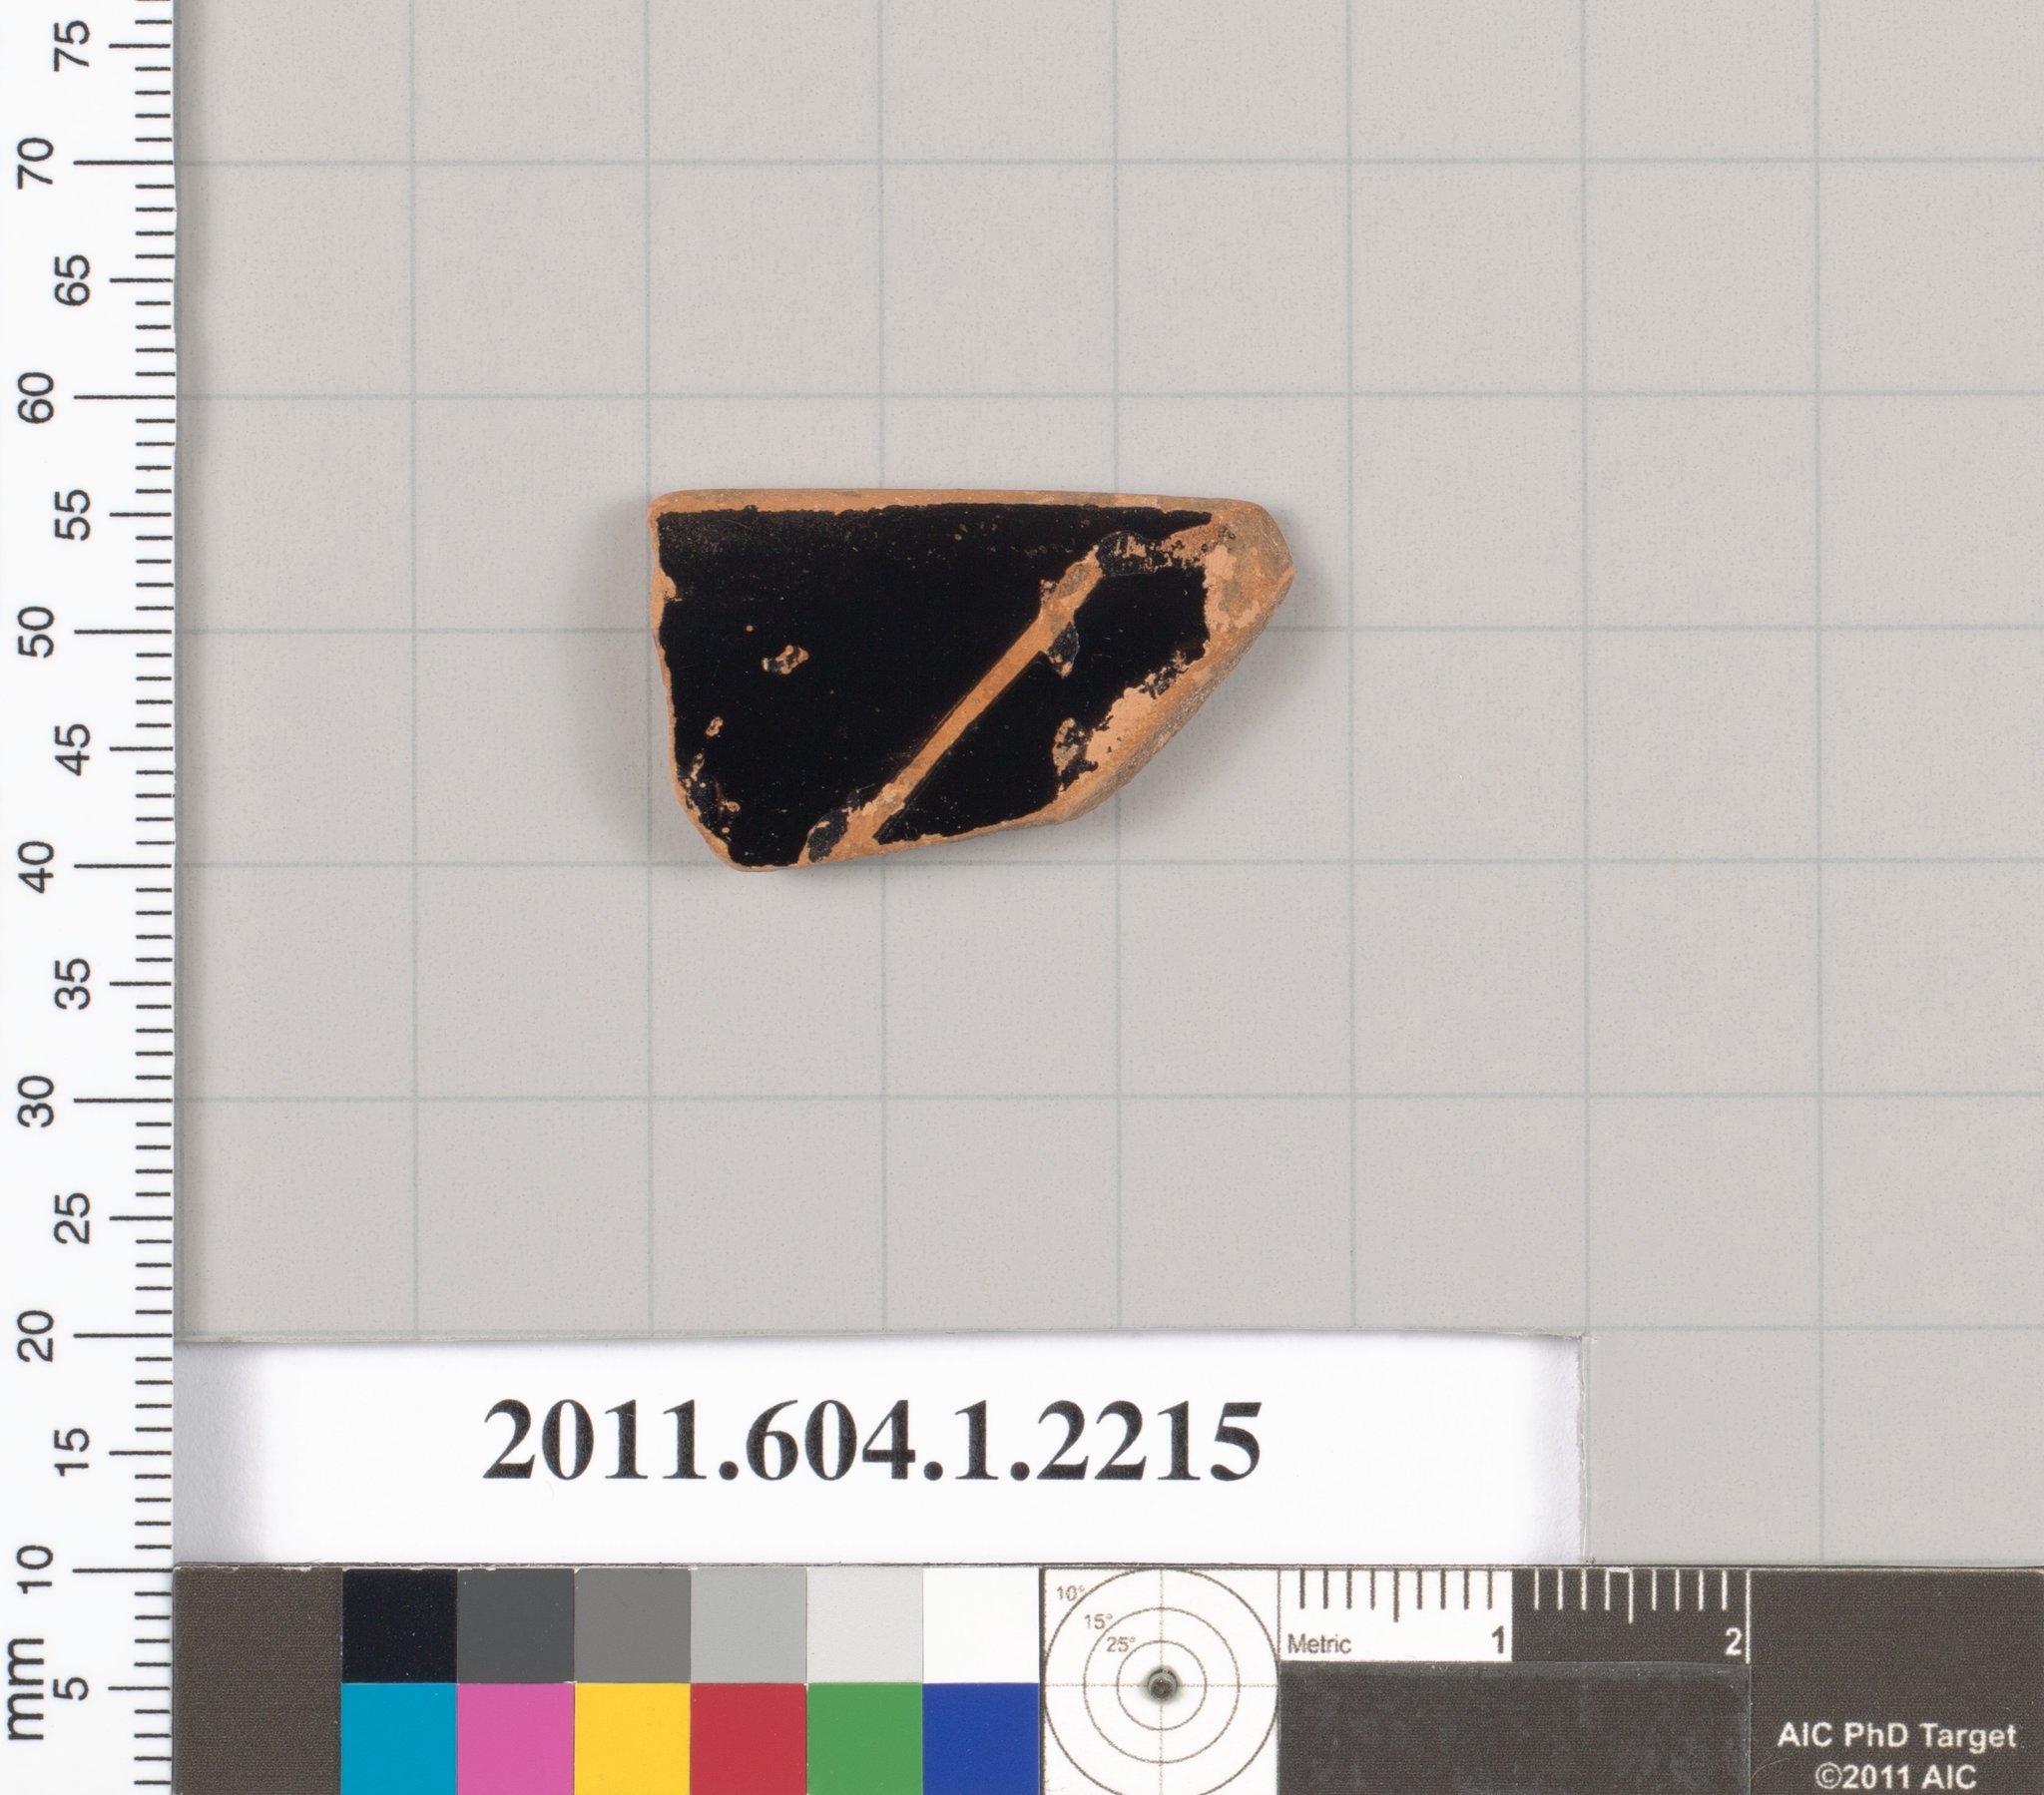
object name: kylix fragment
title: Terracotta rim fragment of a kylix (drinking cup)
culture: greek, attic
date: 500-451 BCE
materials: terracotta